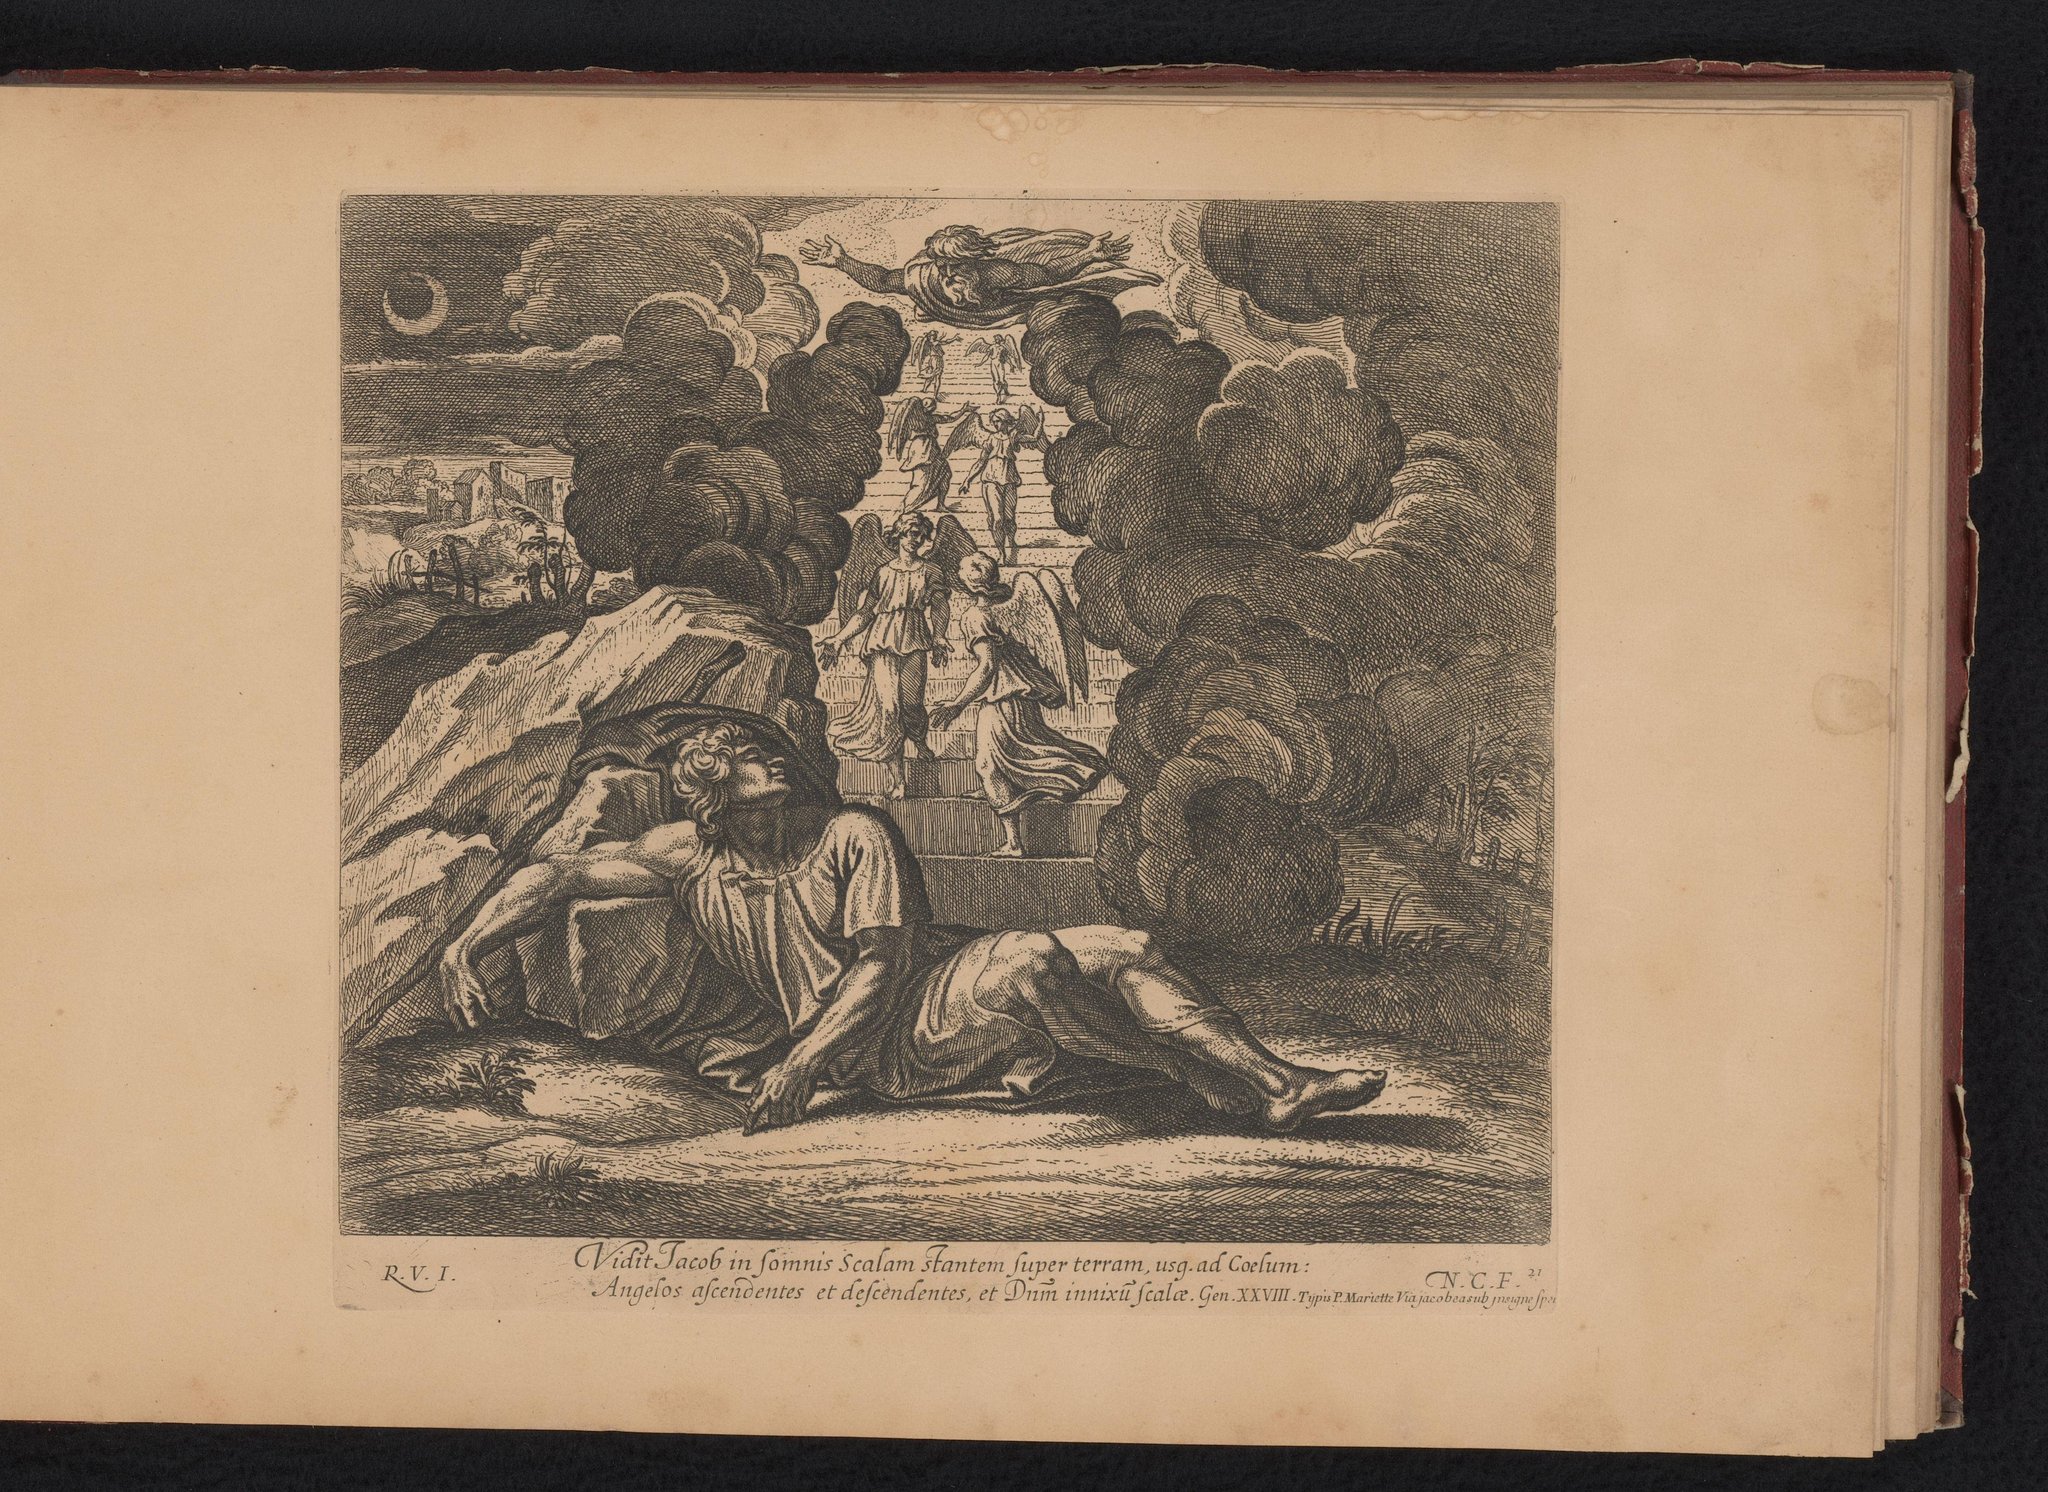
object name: album leaf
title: Sacrae historiae acta a Raphael Urbin in Vaticanis xystis ad picturae miraculum expressa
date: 1649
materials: paper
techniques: etching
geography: paris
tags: isaac's blessing (of jacob and esau) (genesis 27)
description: Deze prent maakt deel uit van een album.